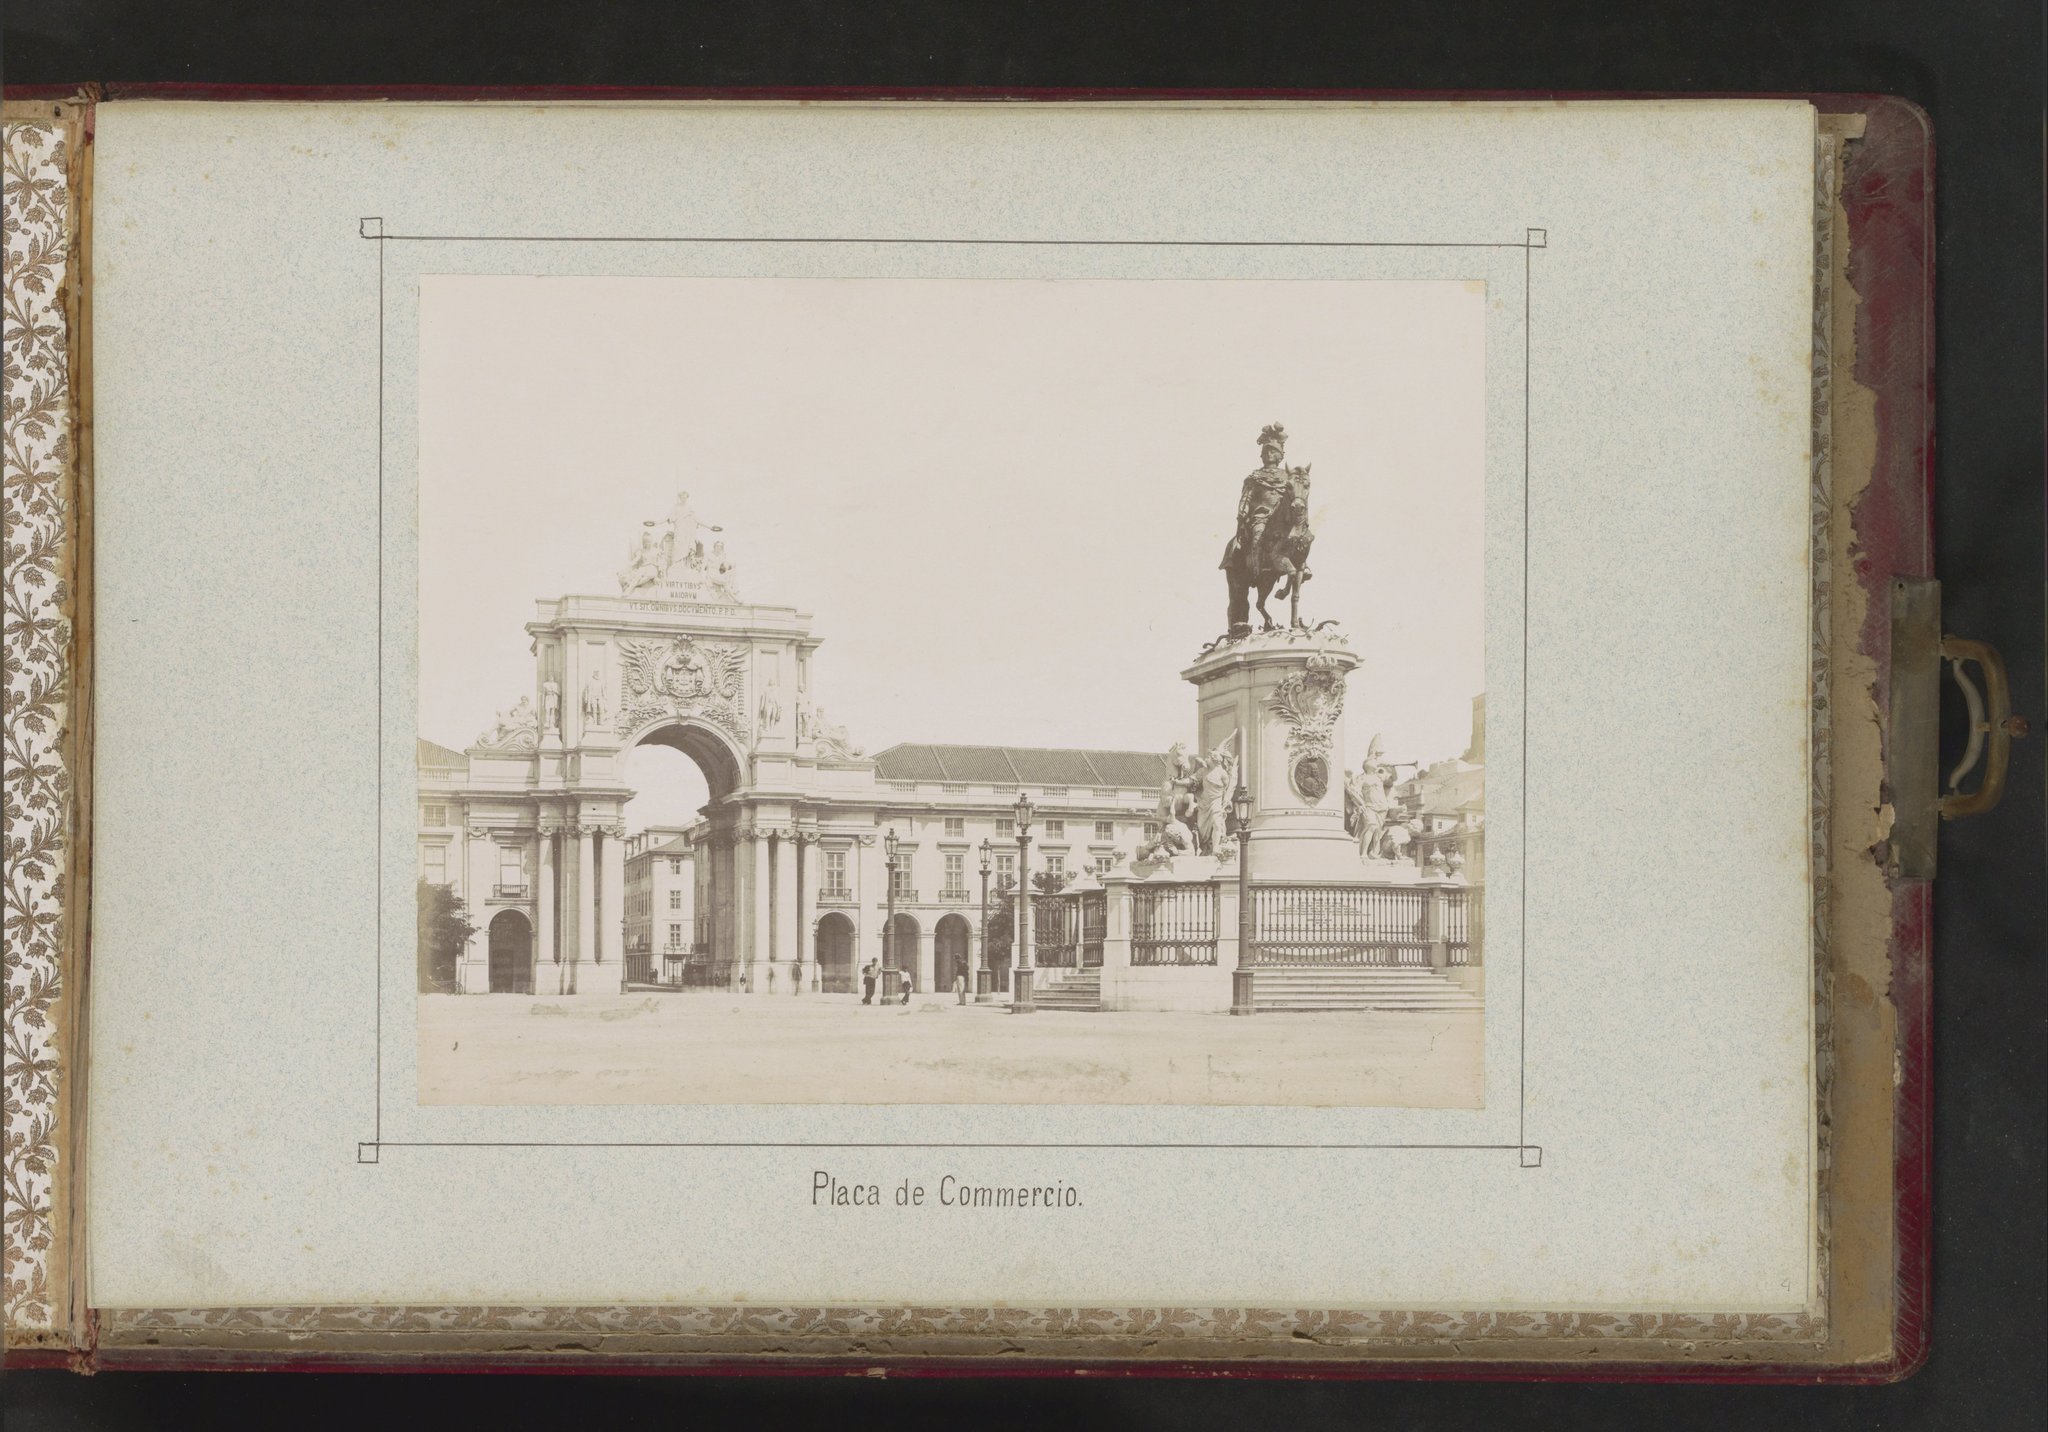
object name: photograph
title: Placa de Commercio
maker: Anonymous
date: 1880-1900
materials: photographic support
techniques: albumen print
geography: praca do comercio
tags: triumphal arch, equestrian statue, square, place, circus, etc. (+ city(-scape) with figures, staffage)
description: Onderdeel van Reisalbum met foto's van Zuid-Afrika, Madeira, Portugal, Frankrijk en Duitsland.